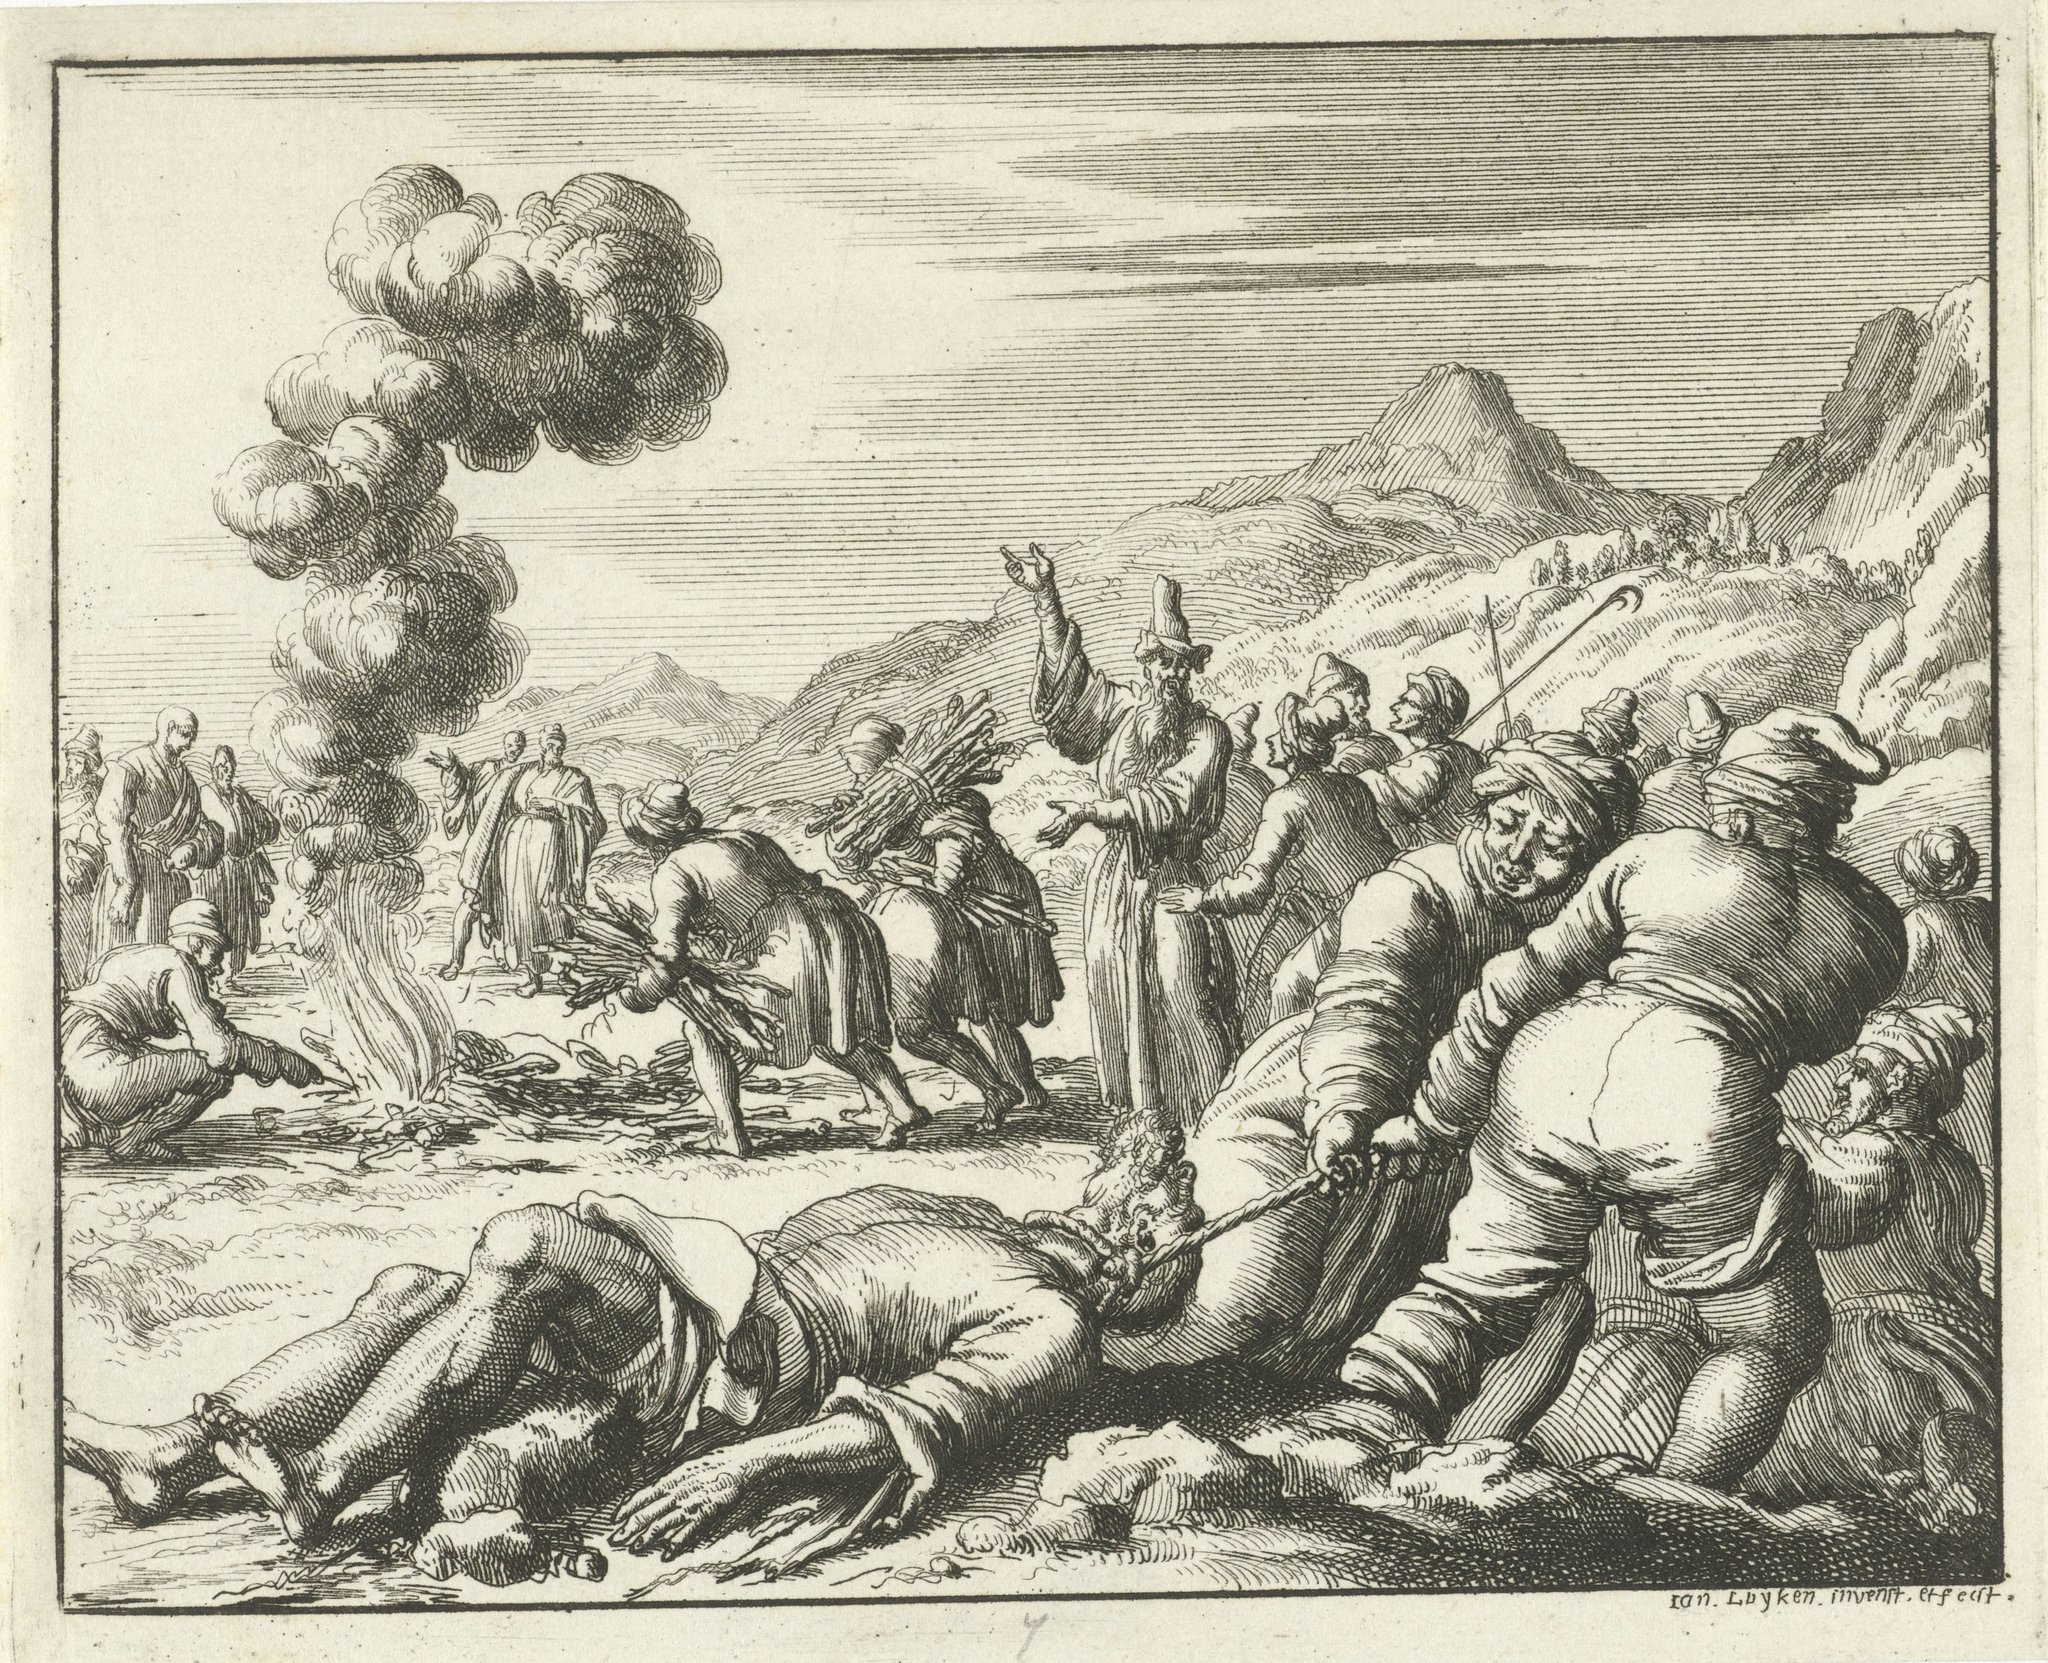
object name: print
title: Barnabas op weg naar de brandstapel op Cyprus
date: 1685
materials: paper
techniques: etching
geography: amsterdam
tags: martyrdom, suffering, misfortune, death of st. barnabas, (person under sentence of death) on the way to the scaffold or place of execution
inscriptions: number: ‘7’, collector's mark: Lugt 2228